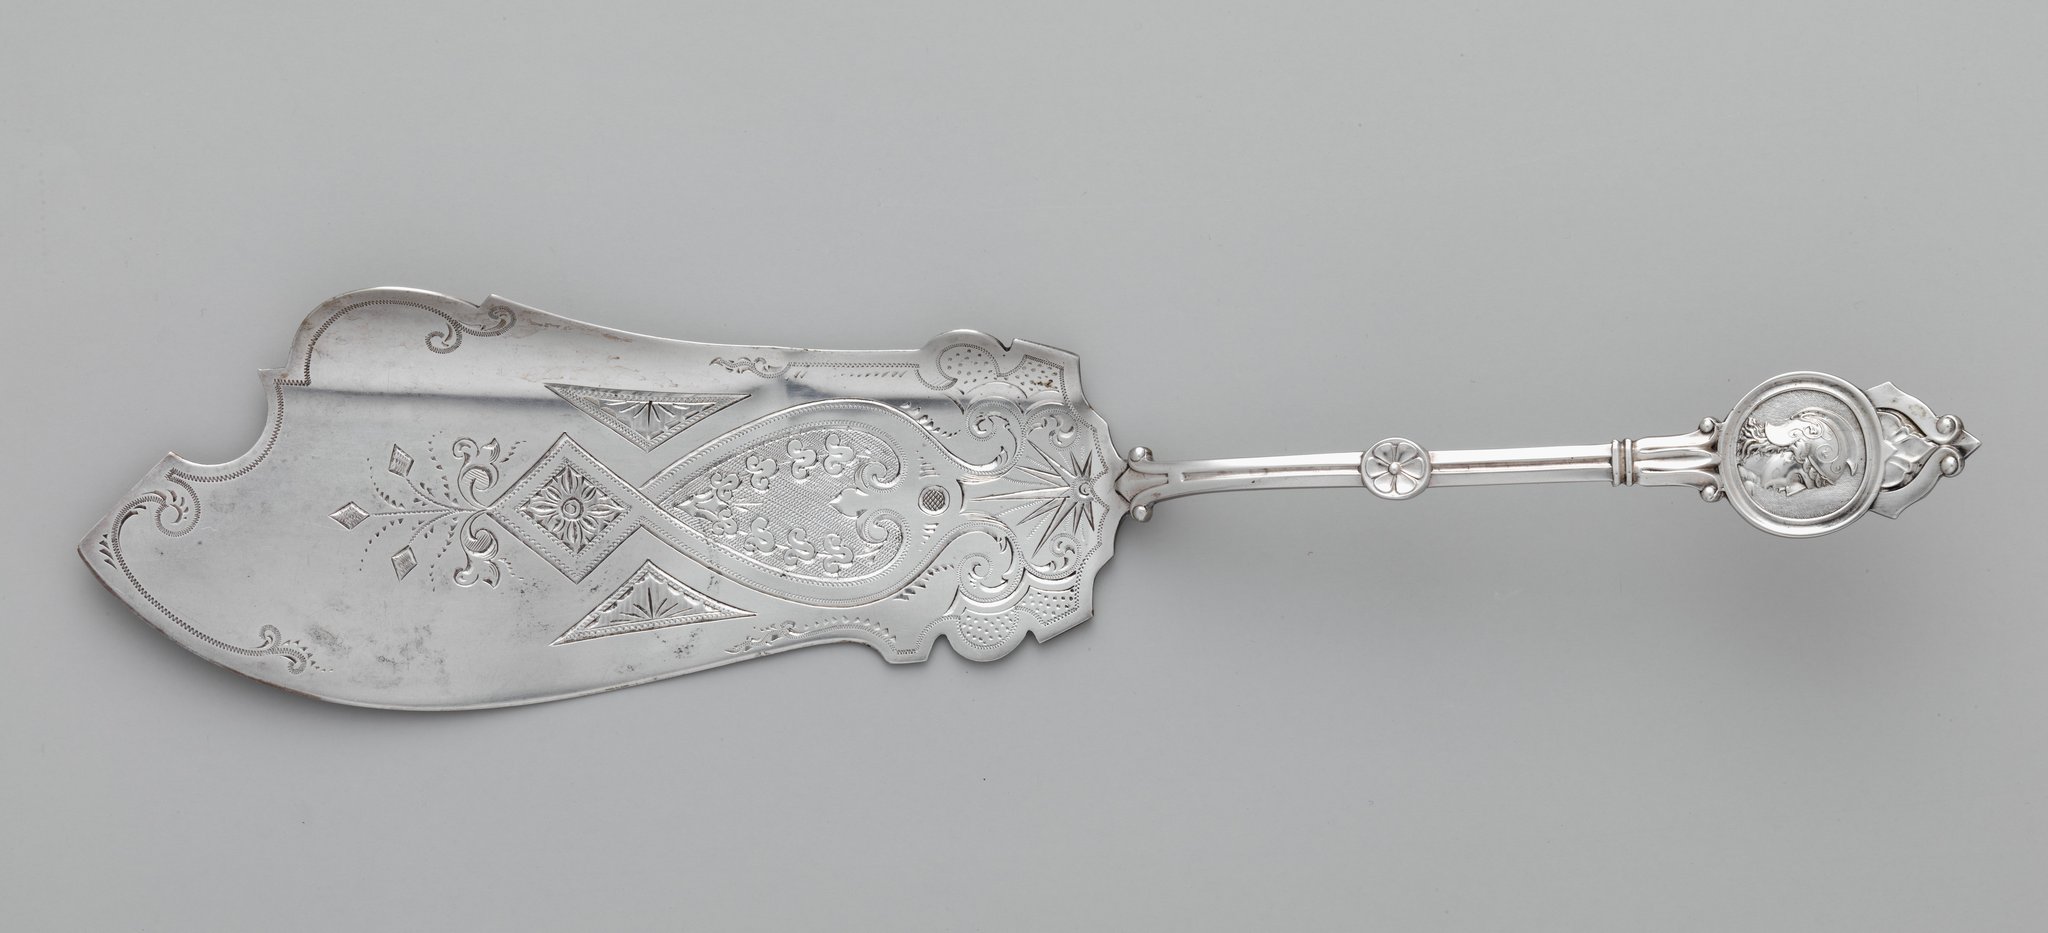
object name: fish slice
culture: american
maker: schulz & fischer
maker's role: maker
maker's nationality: american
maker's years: 1868-1887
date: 1872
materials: silver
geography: united states